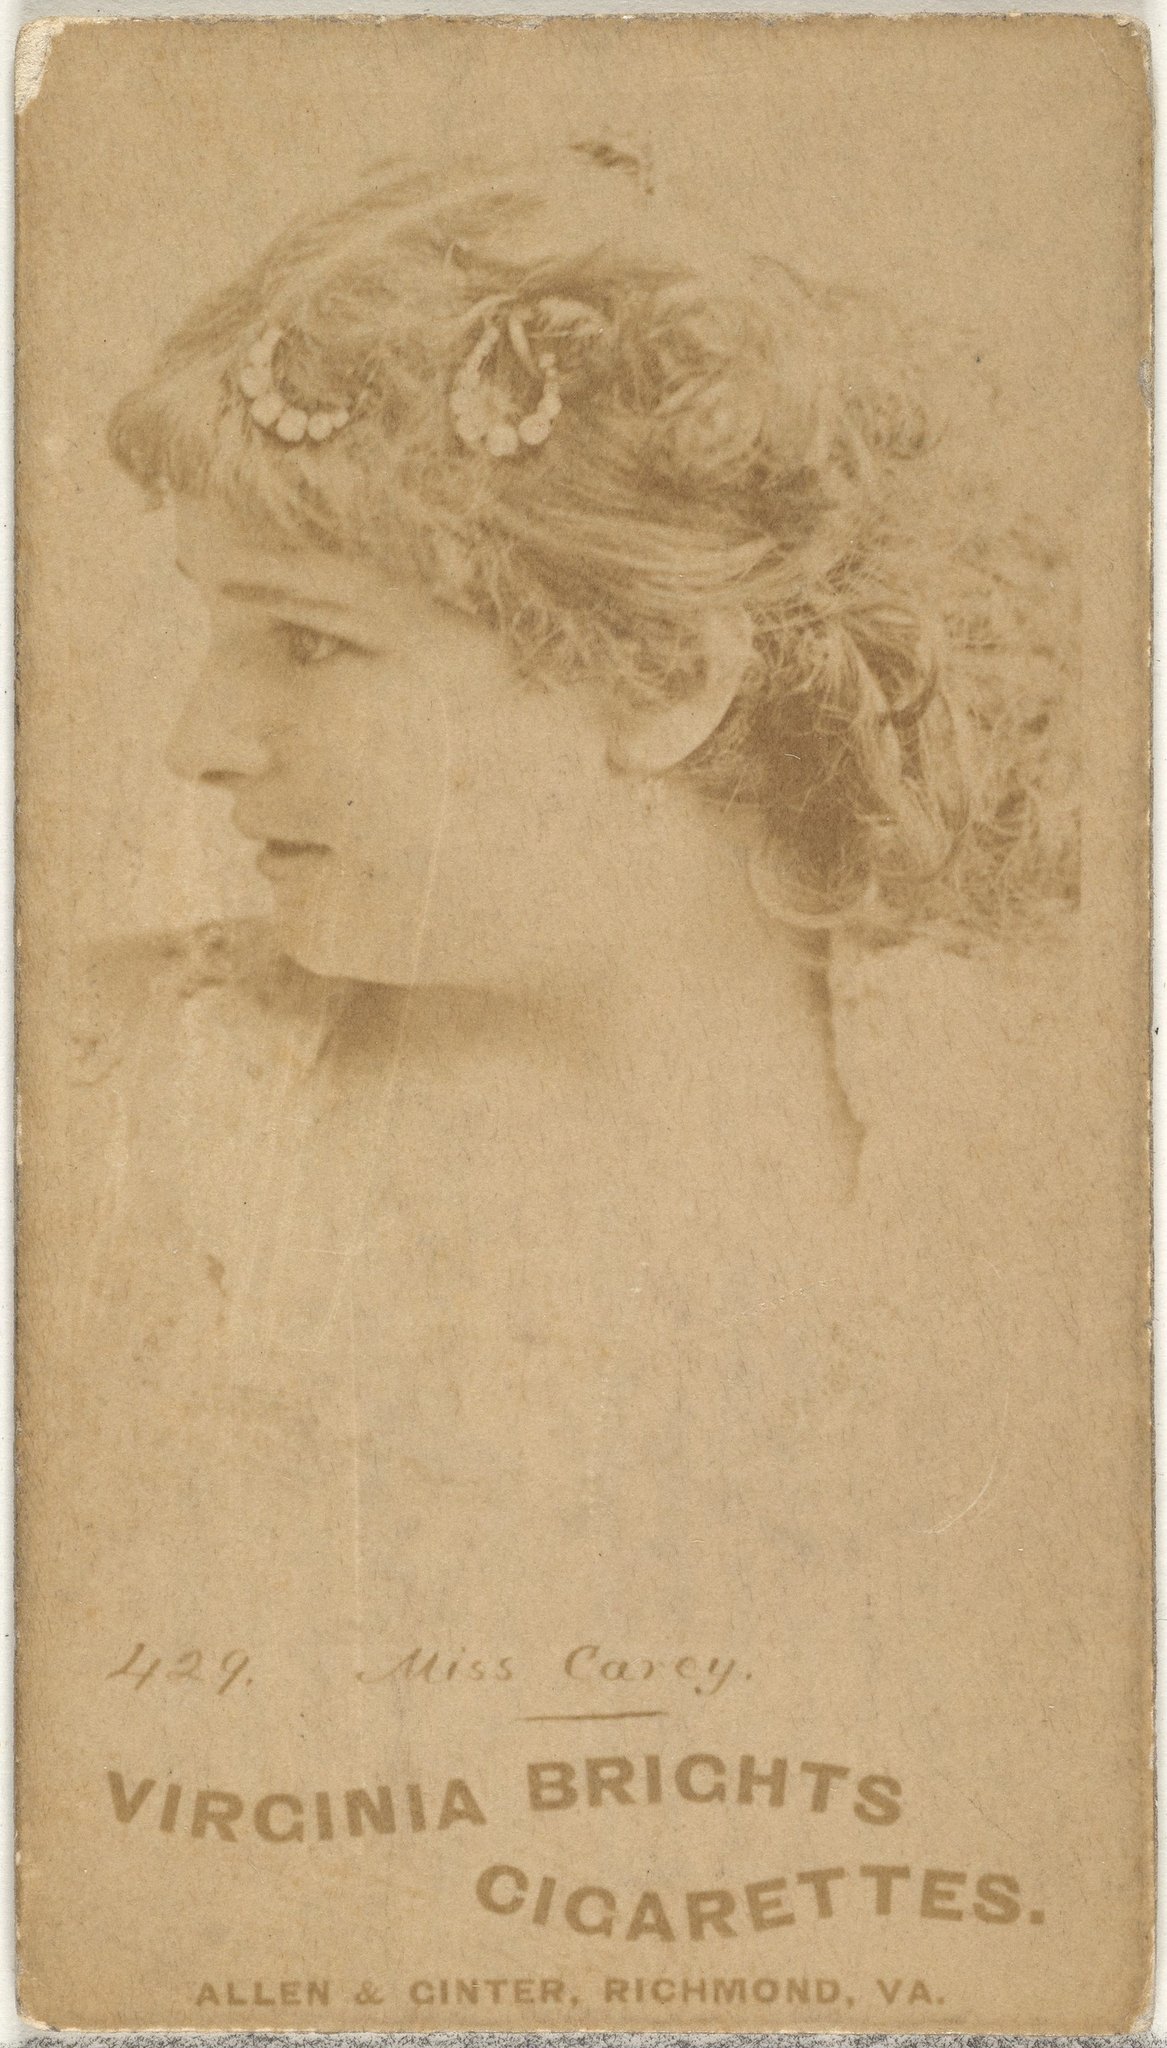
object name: photograph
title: Card 429, Miss Carey, from the Actors and Actresses series (N45, Type 1) for Virginia Brights Cigarettes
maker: allen & ginter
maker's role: publisher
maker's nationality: american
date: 1888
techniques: albumen silver print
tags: portraits,profiles,women,actresses